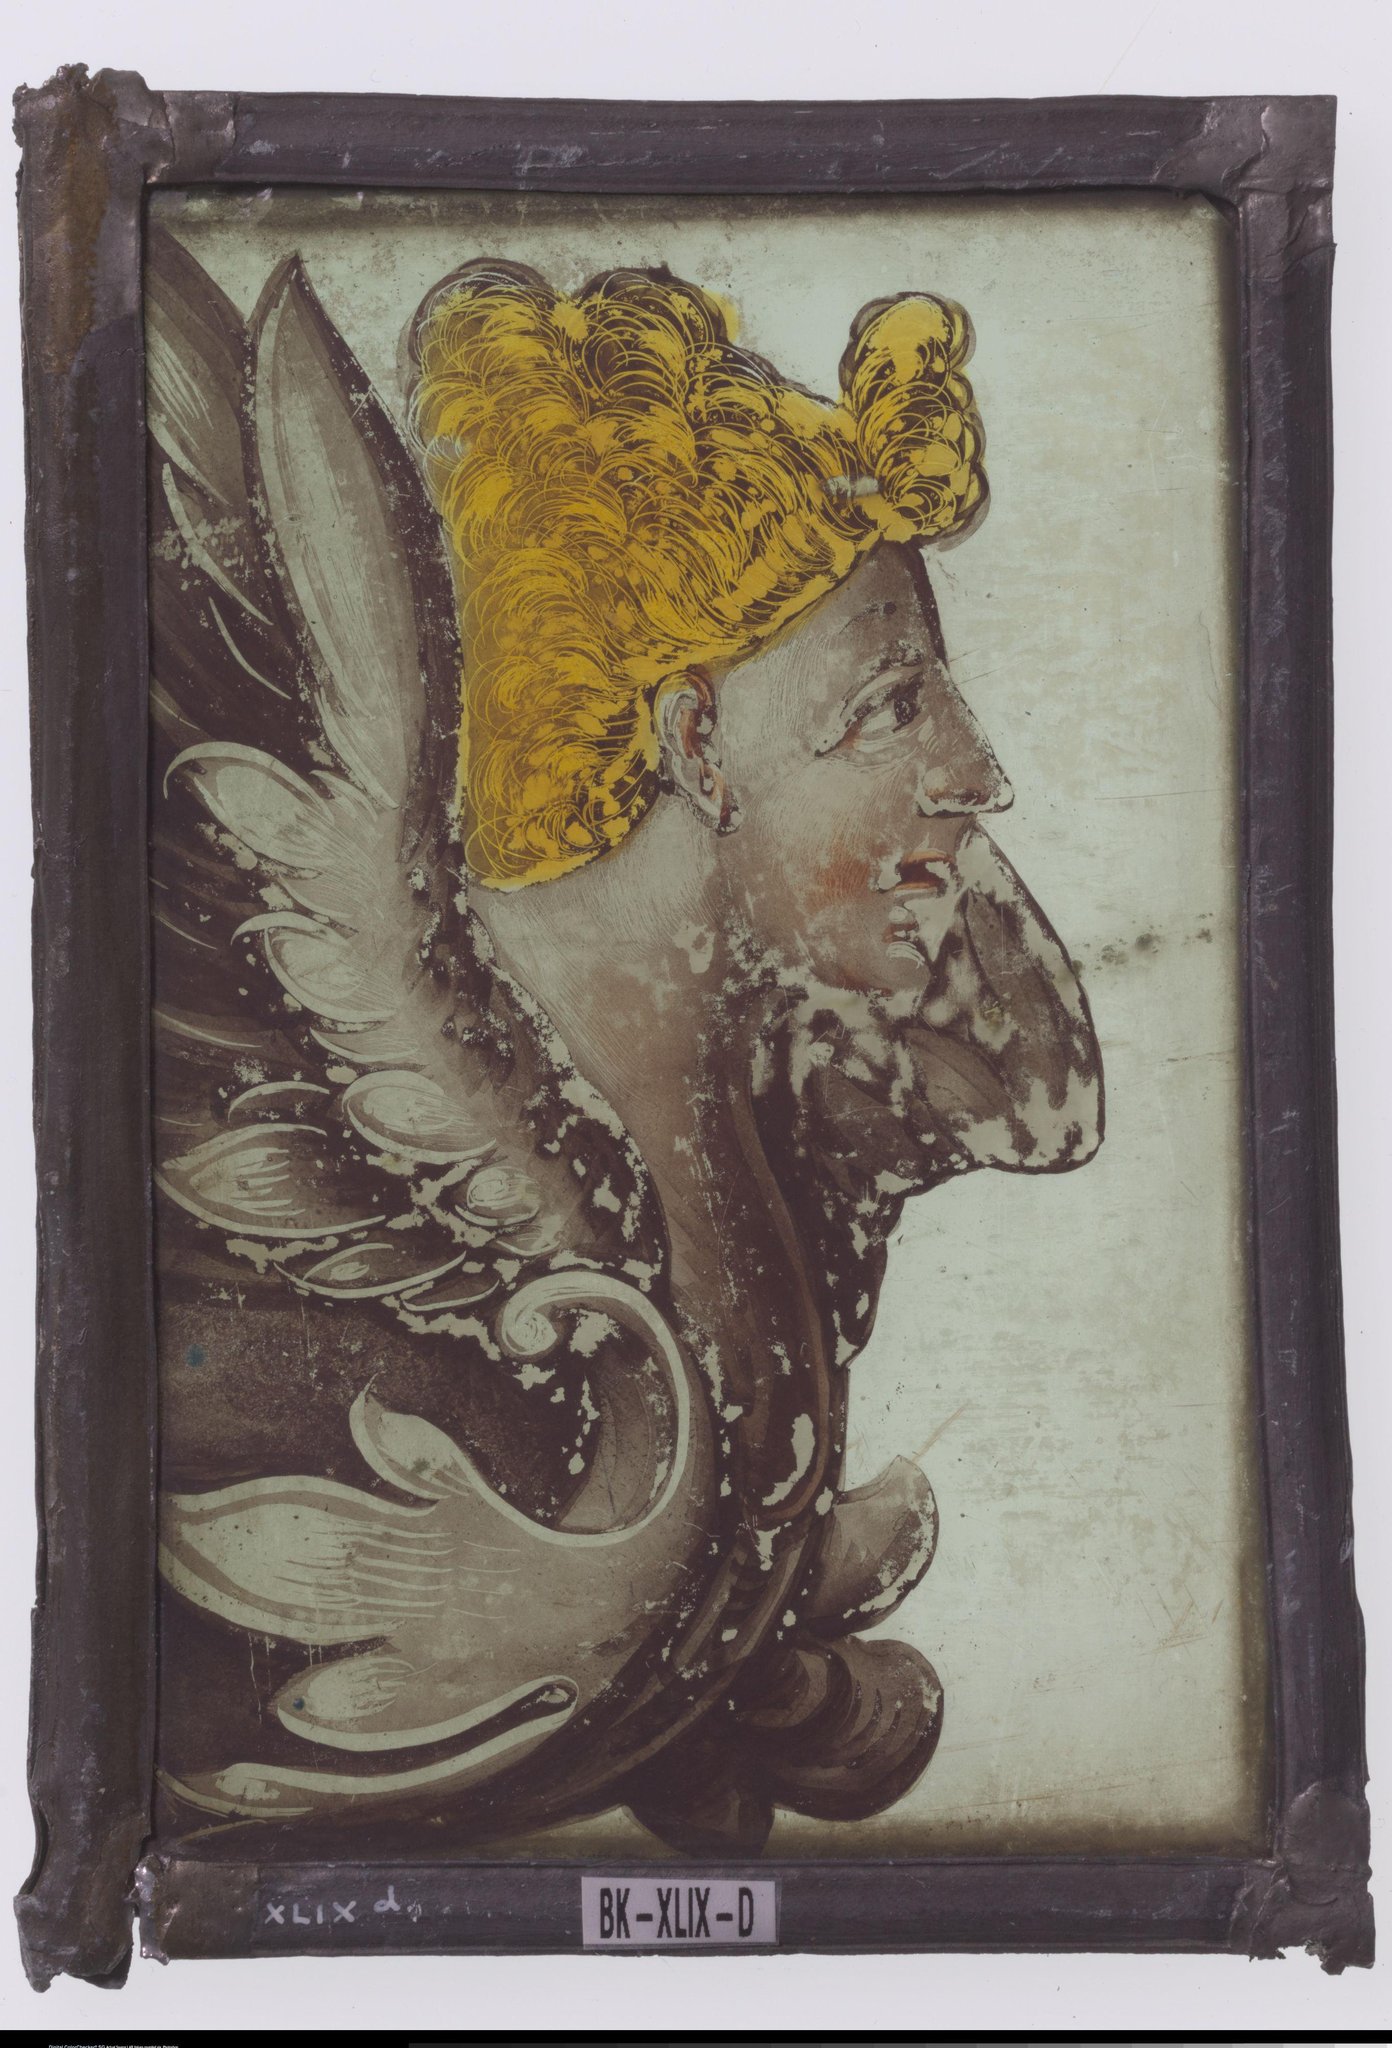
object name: light window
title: Ruit met engelenfiguur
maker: Anonymous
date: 1600-1699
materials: glass, lead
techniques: leading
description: Een fragment van een ruit, voorstellende een engel met blond haar. Behoort tot groep inv. nrs. BK-XLIX-A t/m G.